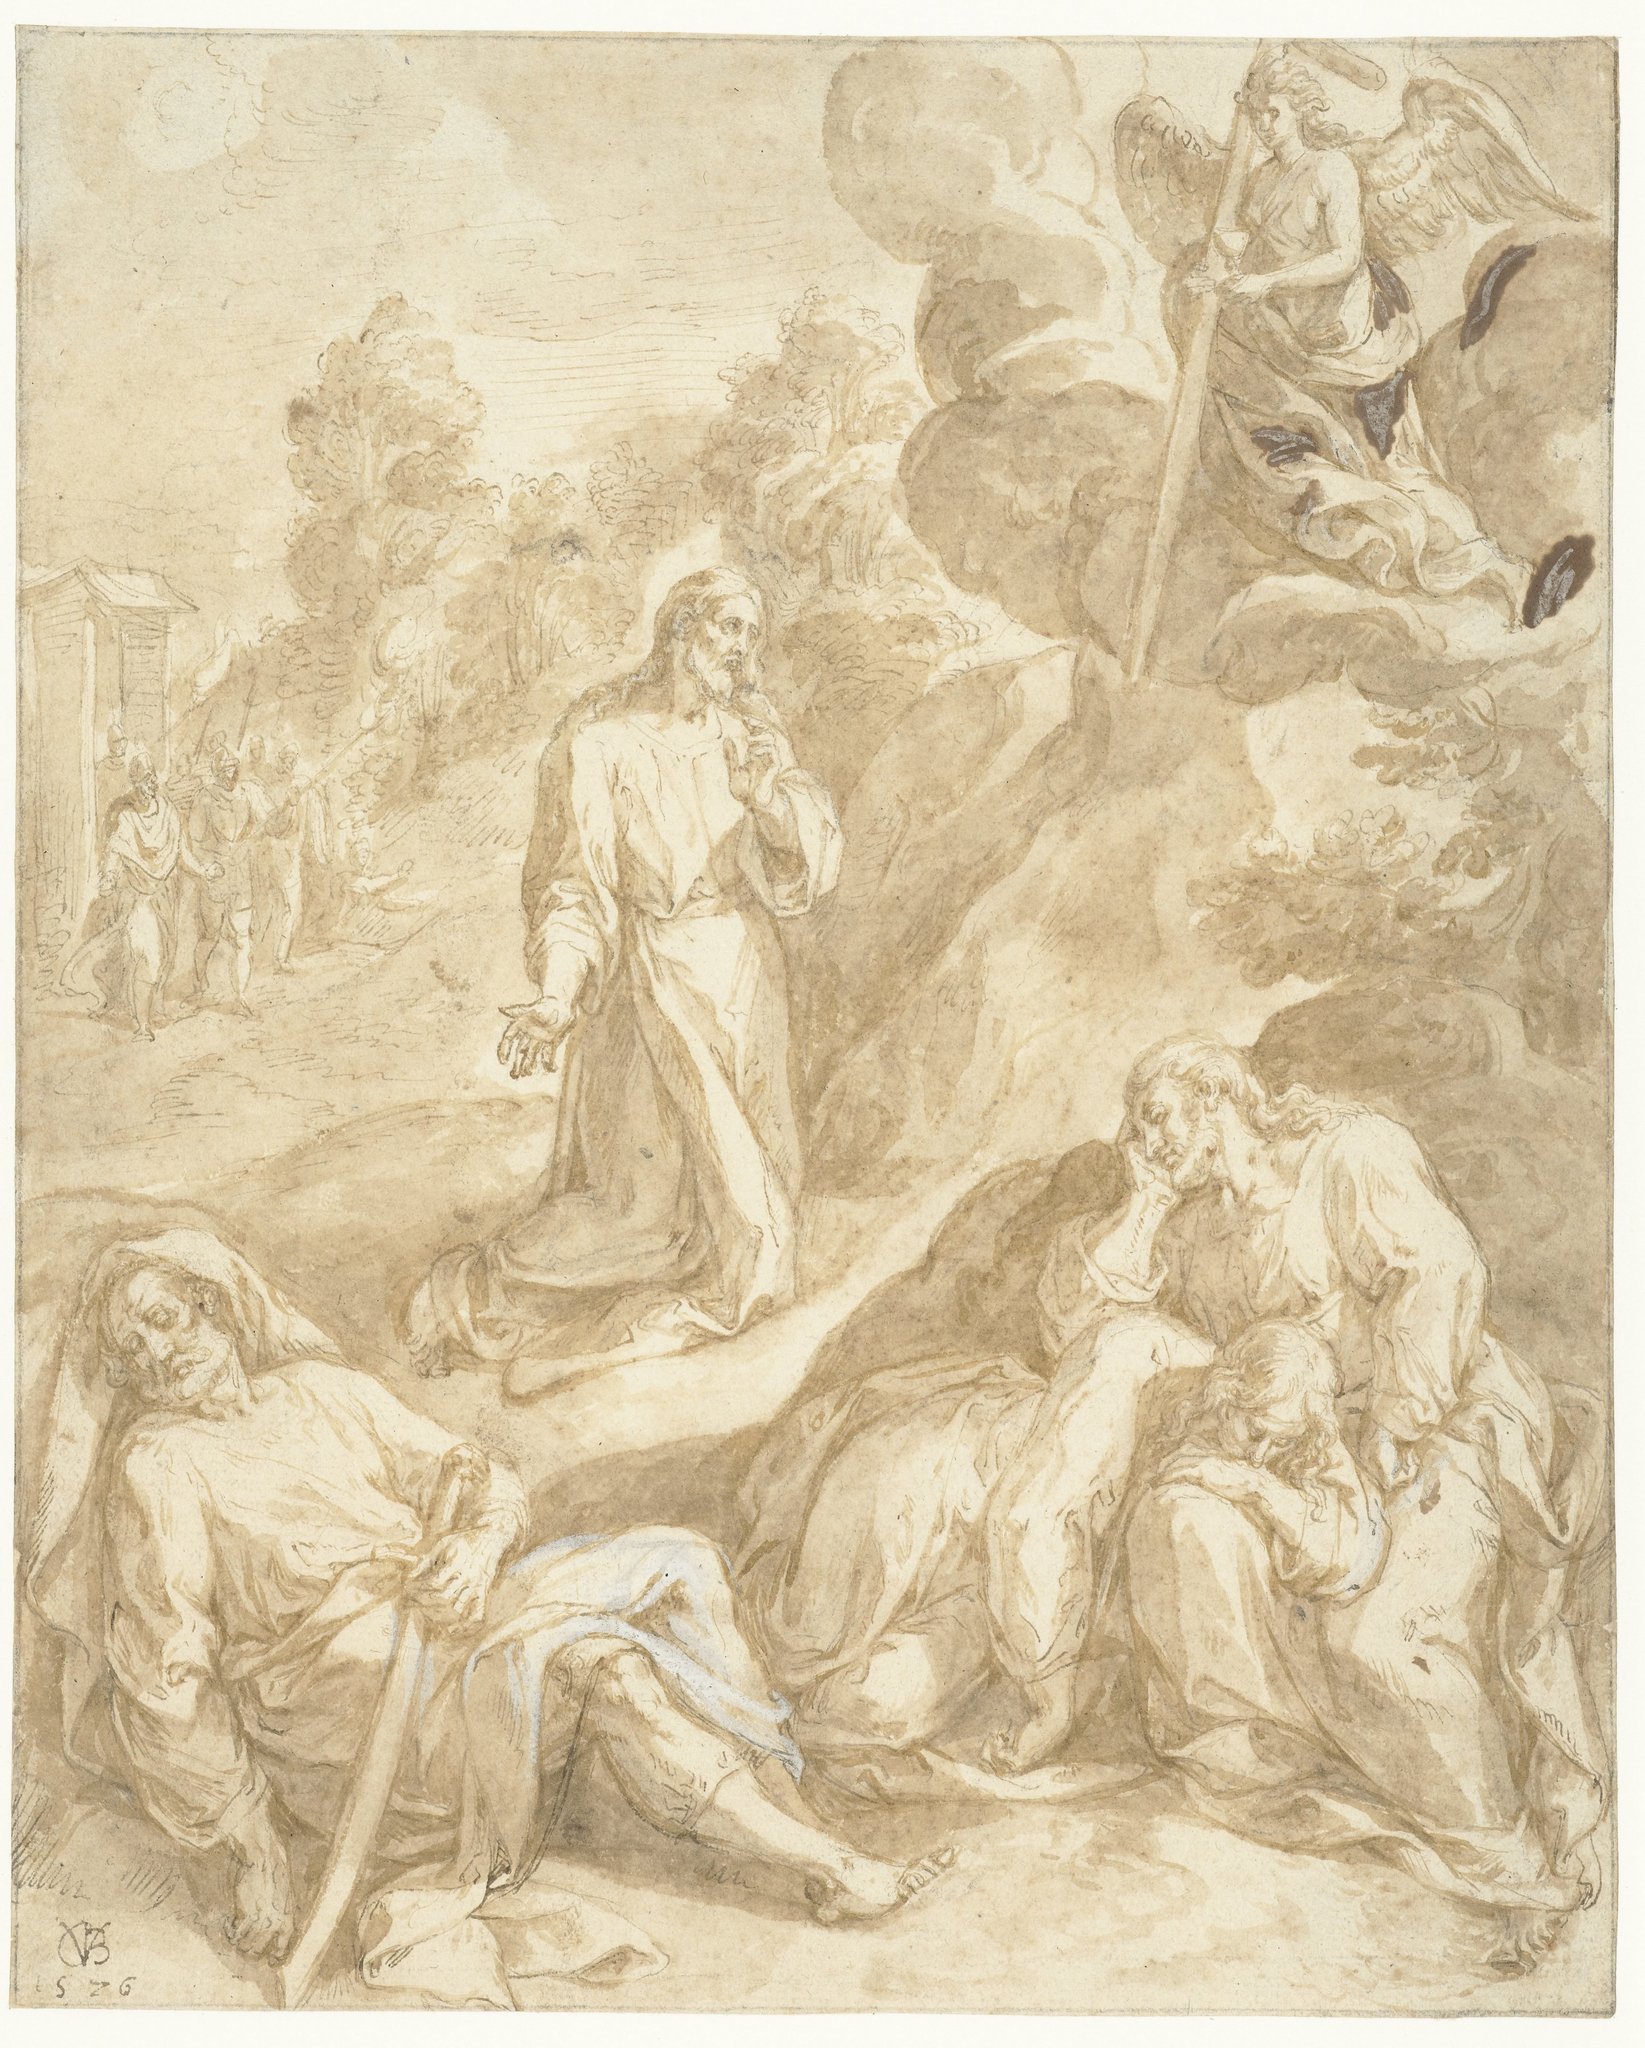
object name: drawing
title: Christus in Gethsemane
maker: chrispijn van den broeck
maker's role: draughtsman, painter, print maker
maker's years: 1530-1591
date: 1576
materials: ink, paint, paper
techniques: brush, pen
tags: gethsemane, mount of olives, 'oelberg' (matthew 26:36-56; mark 14:32-52; luke 22:39-53; john 18:1-12)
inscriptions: date